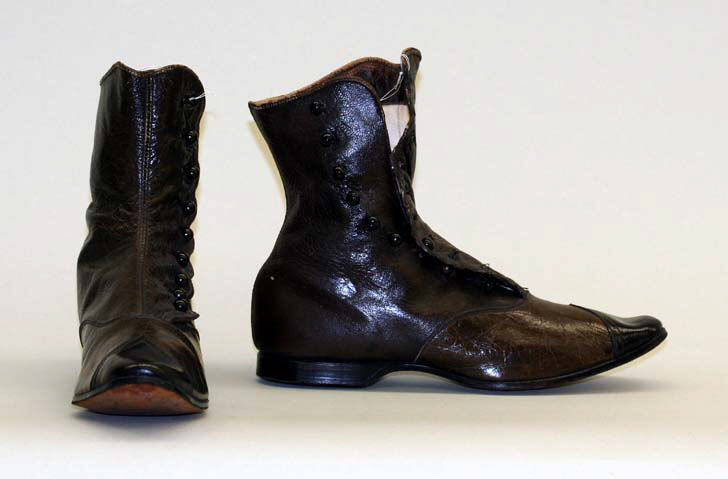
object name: boot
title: Boots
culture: american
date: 1900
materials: leather